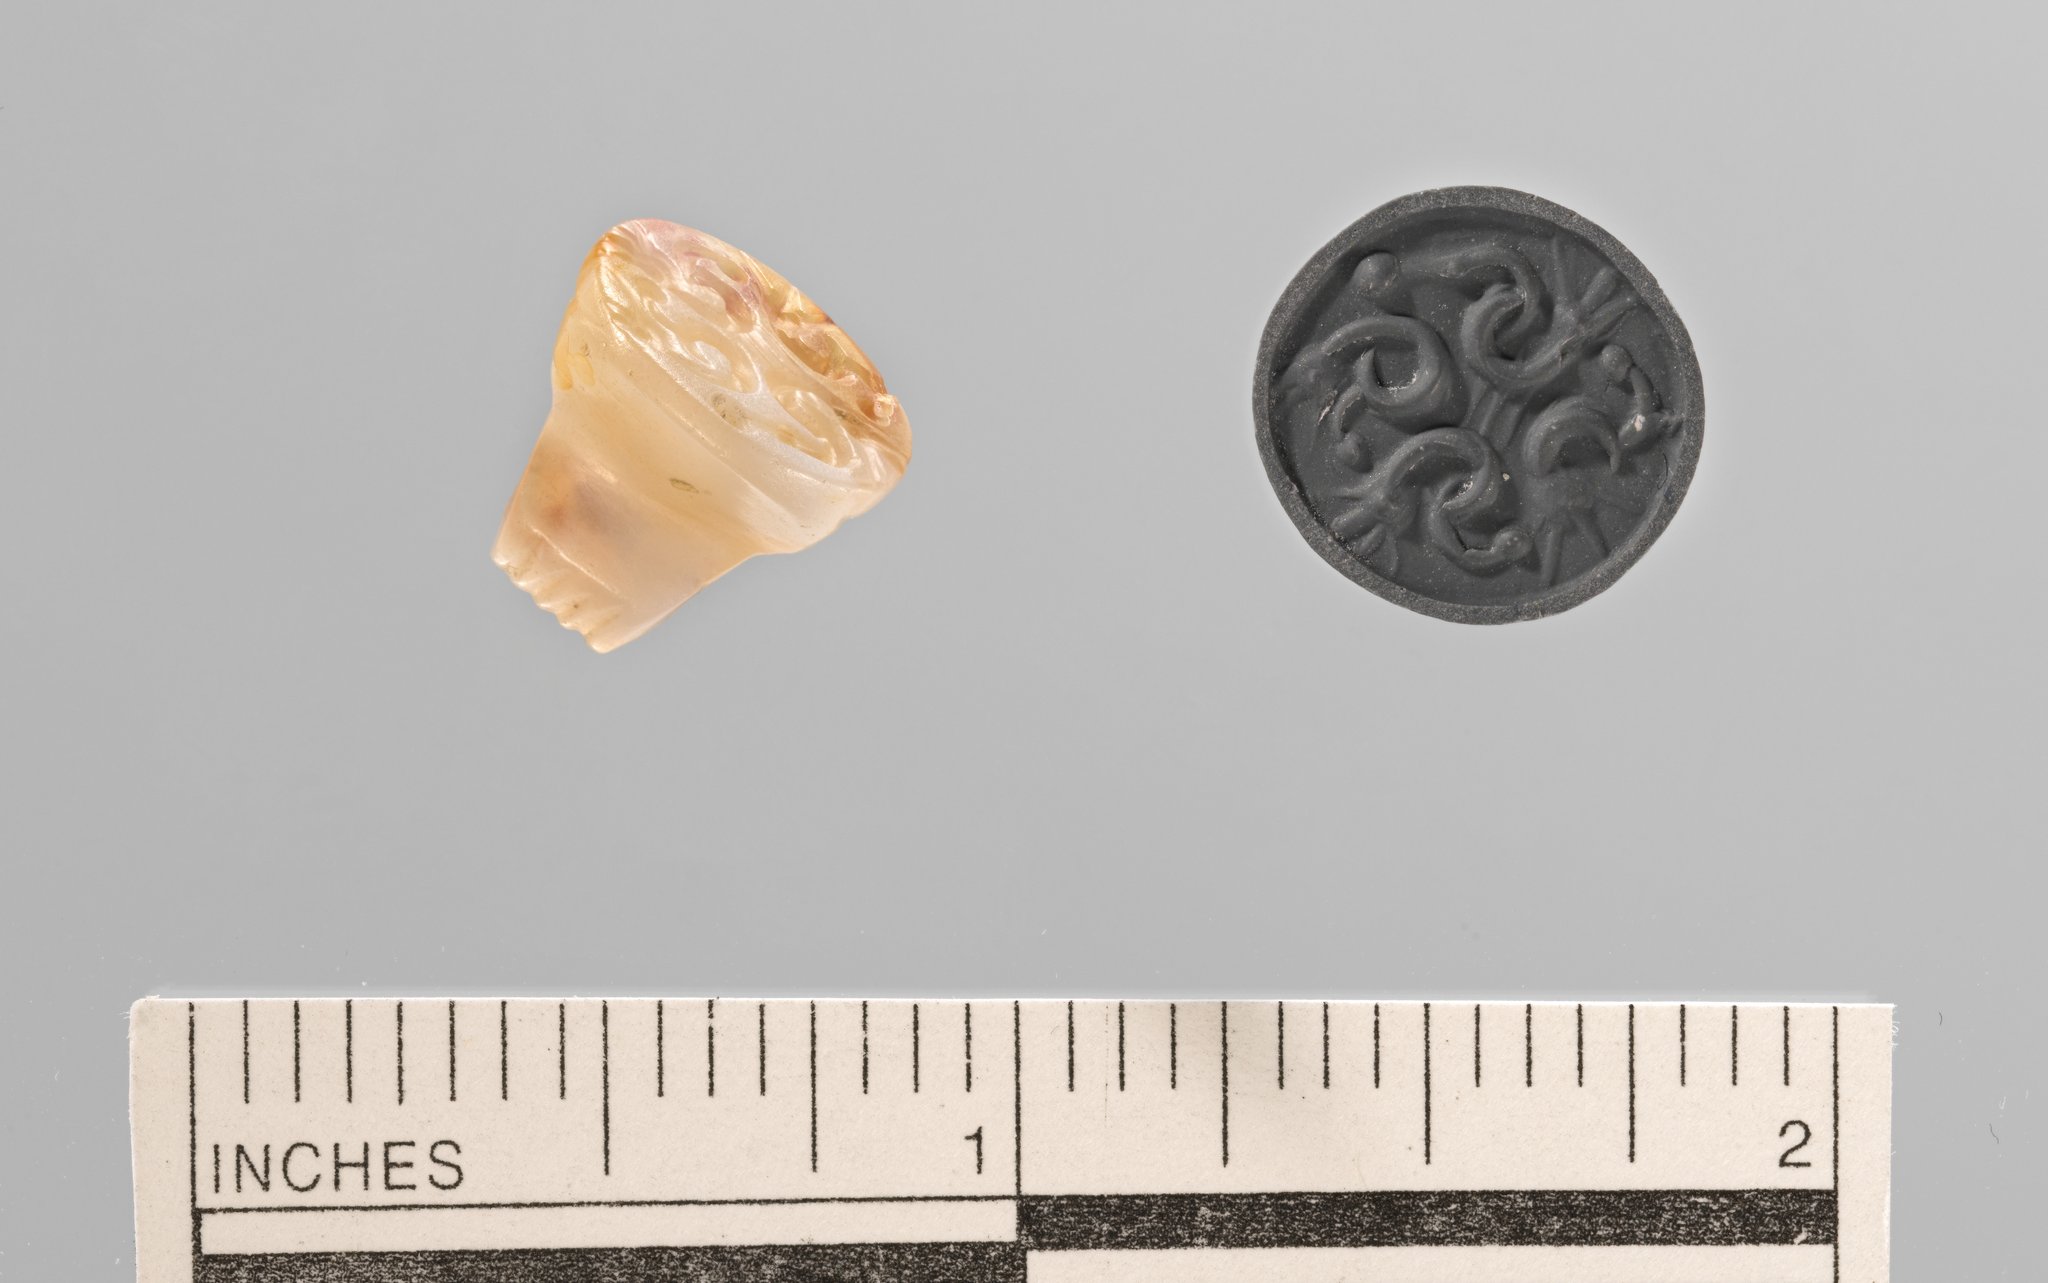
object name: seal, loop handled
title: Agate Loop-handled Signet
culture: minoan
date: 1800-1700 BCE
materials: stone